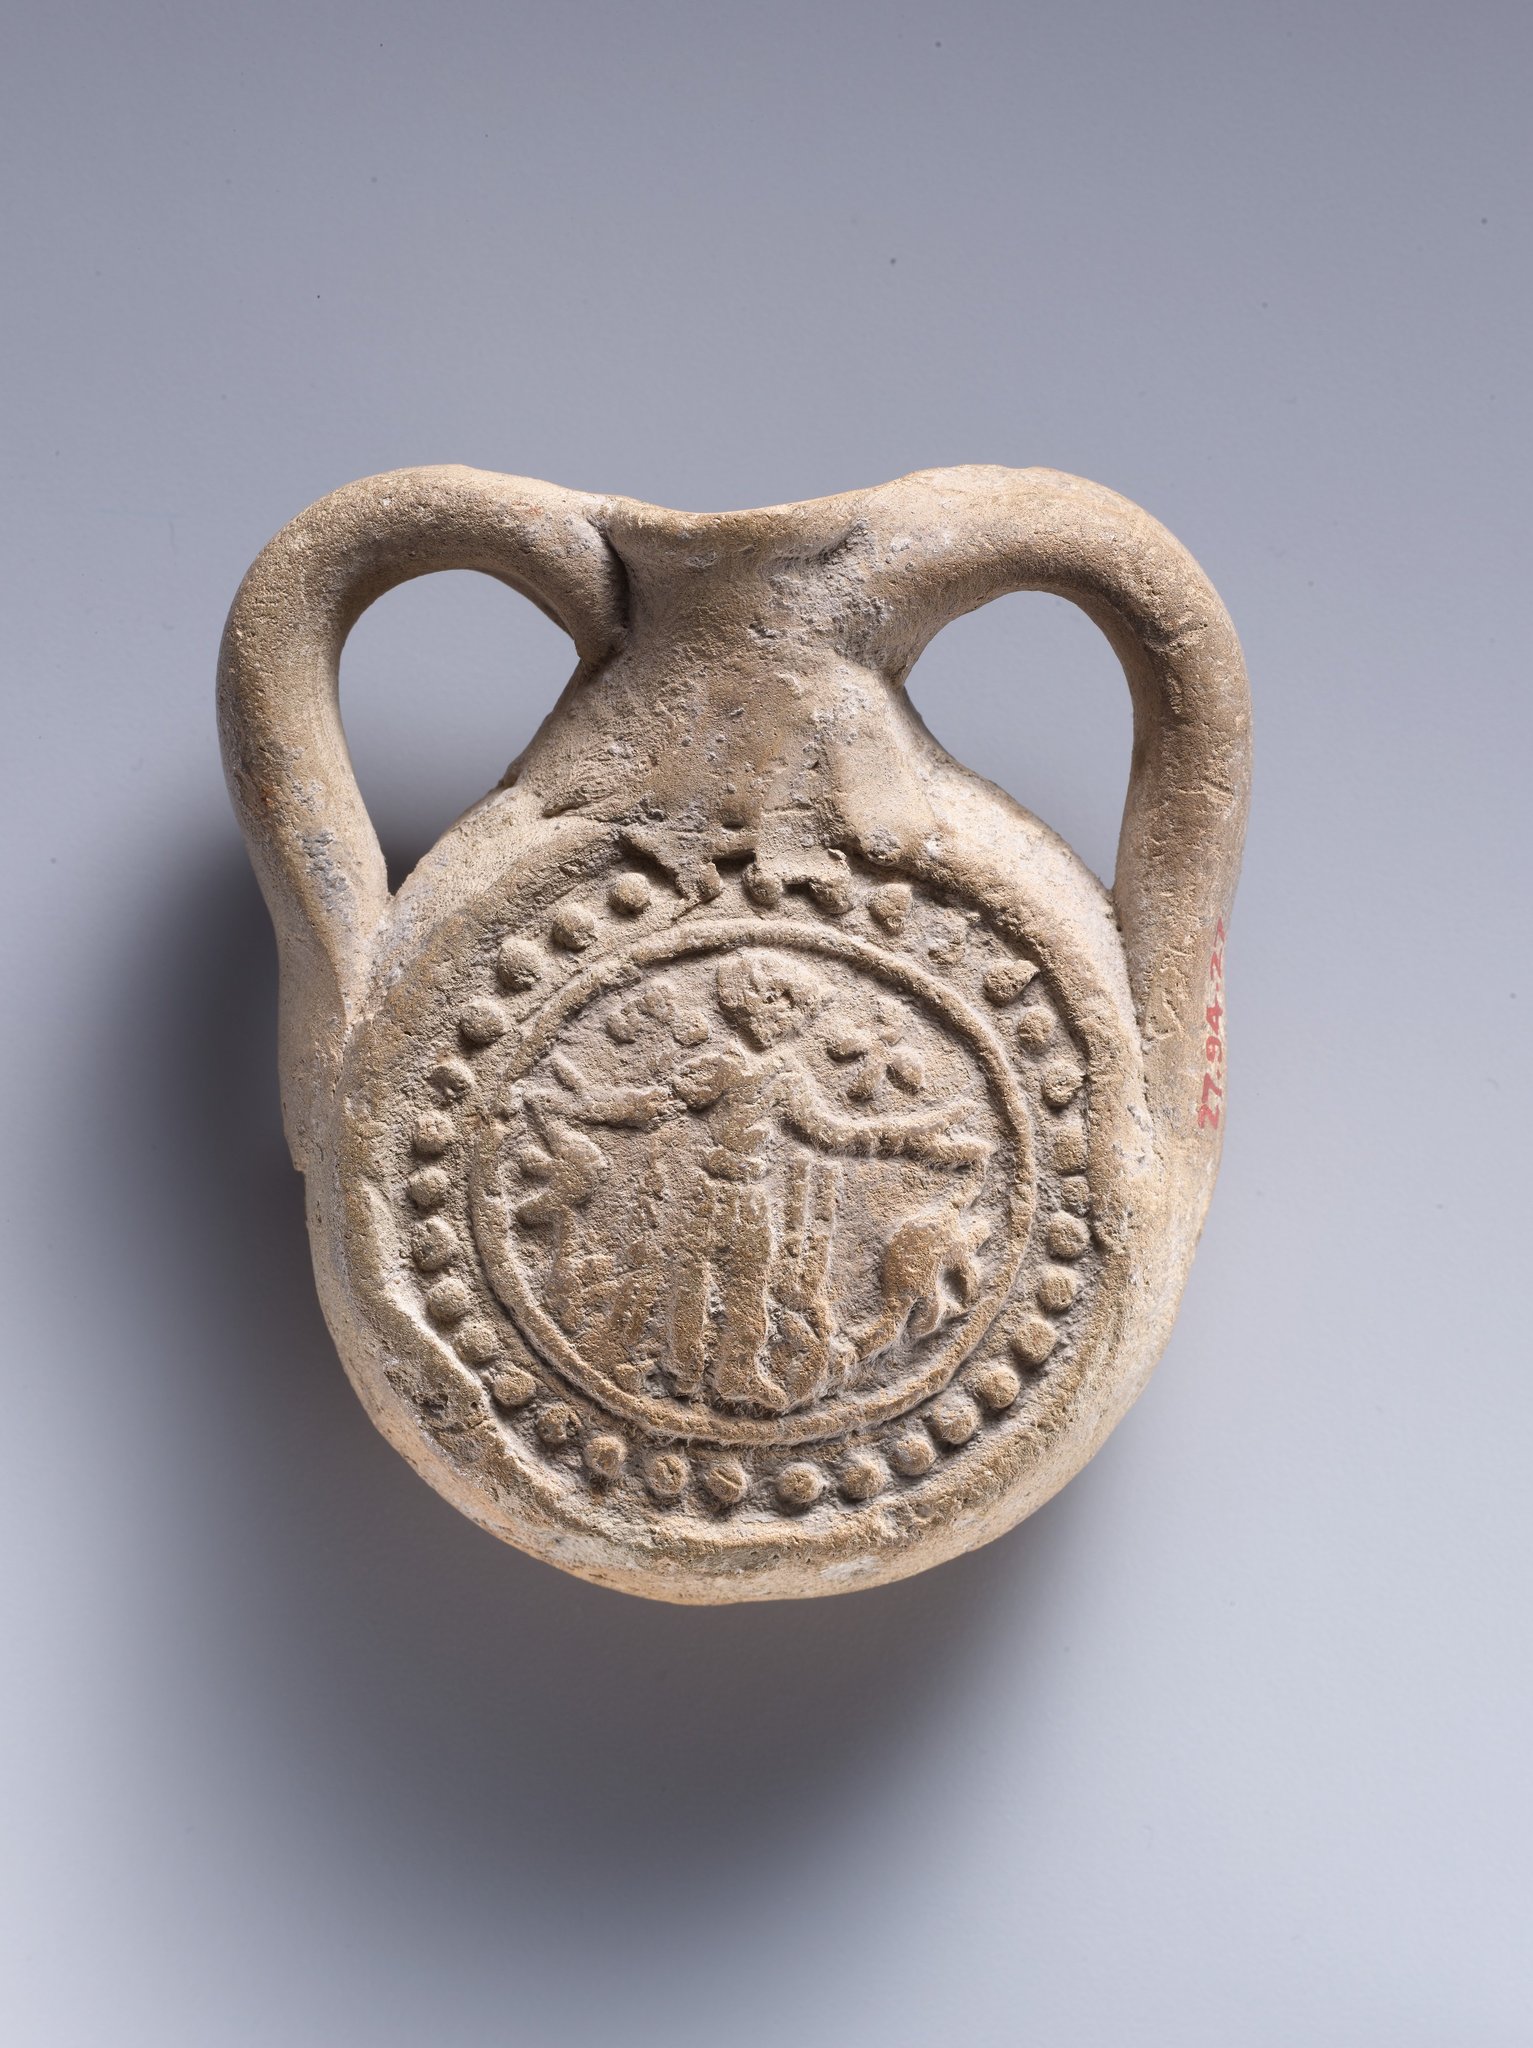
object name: pilgrim flask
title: Ampulla (Flask) with Saint Menas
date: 567-766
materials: earthenware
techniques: molding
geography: egypt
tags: saints